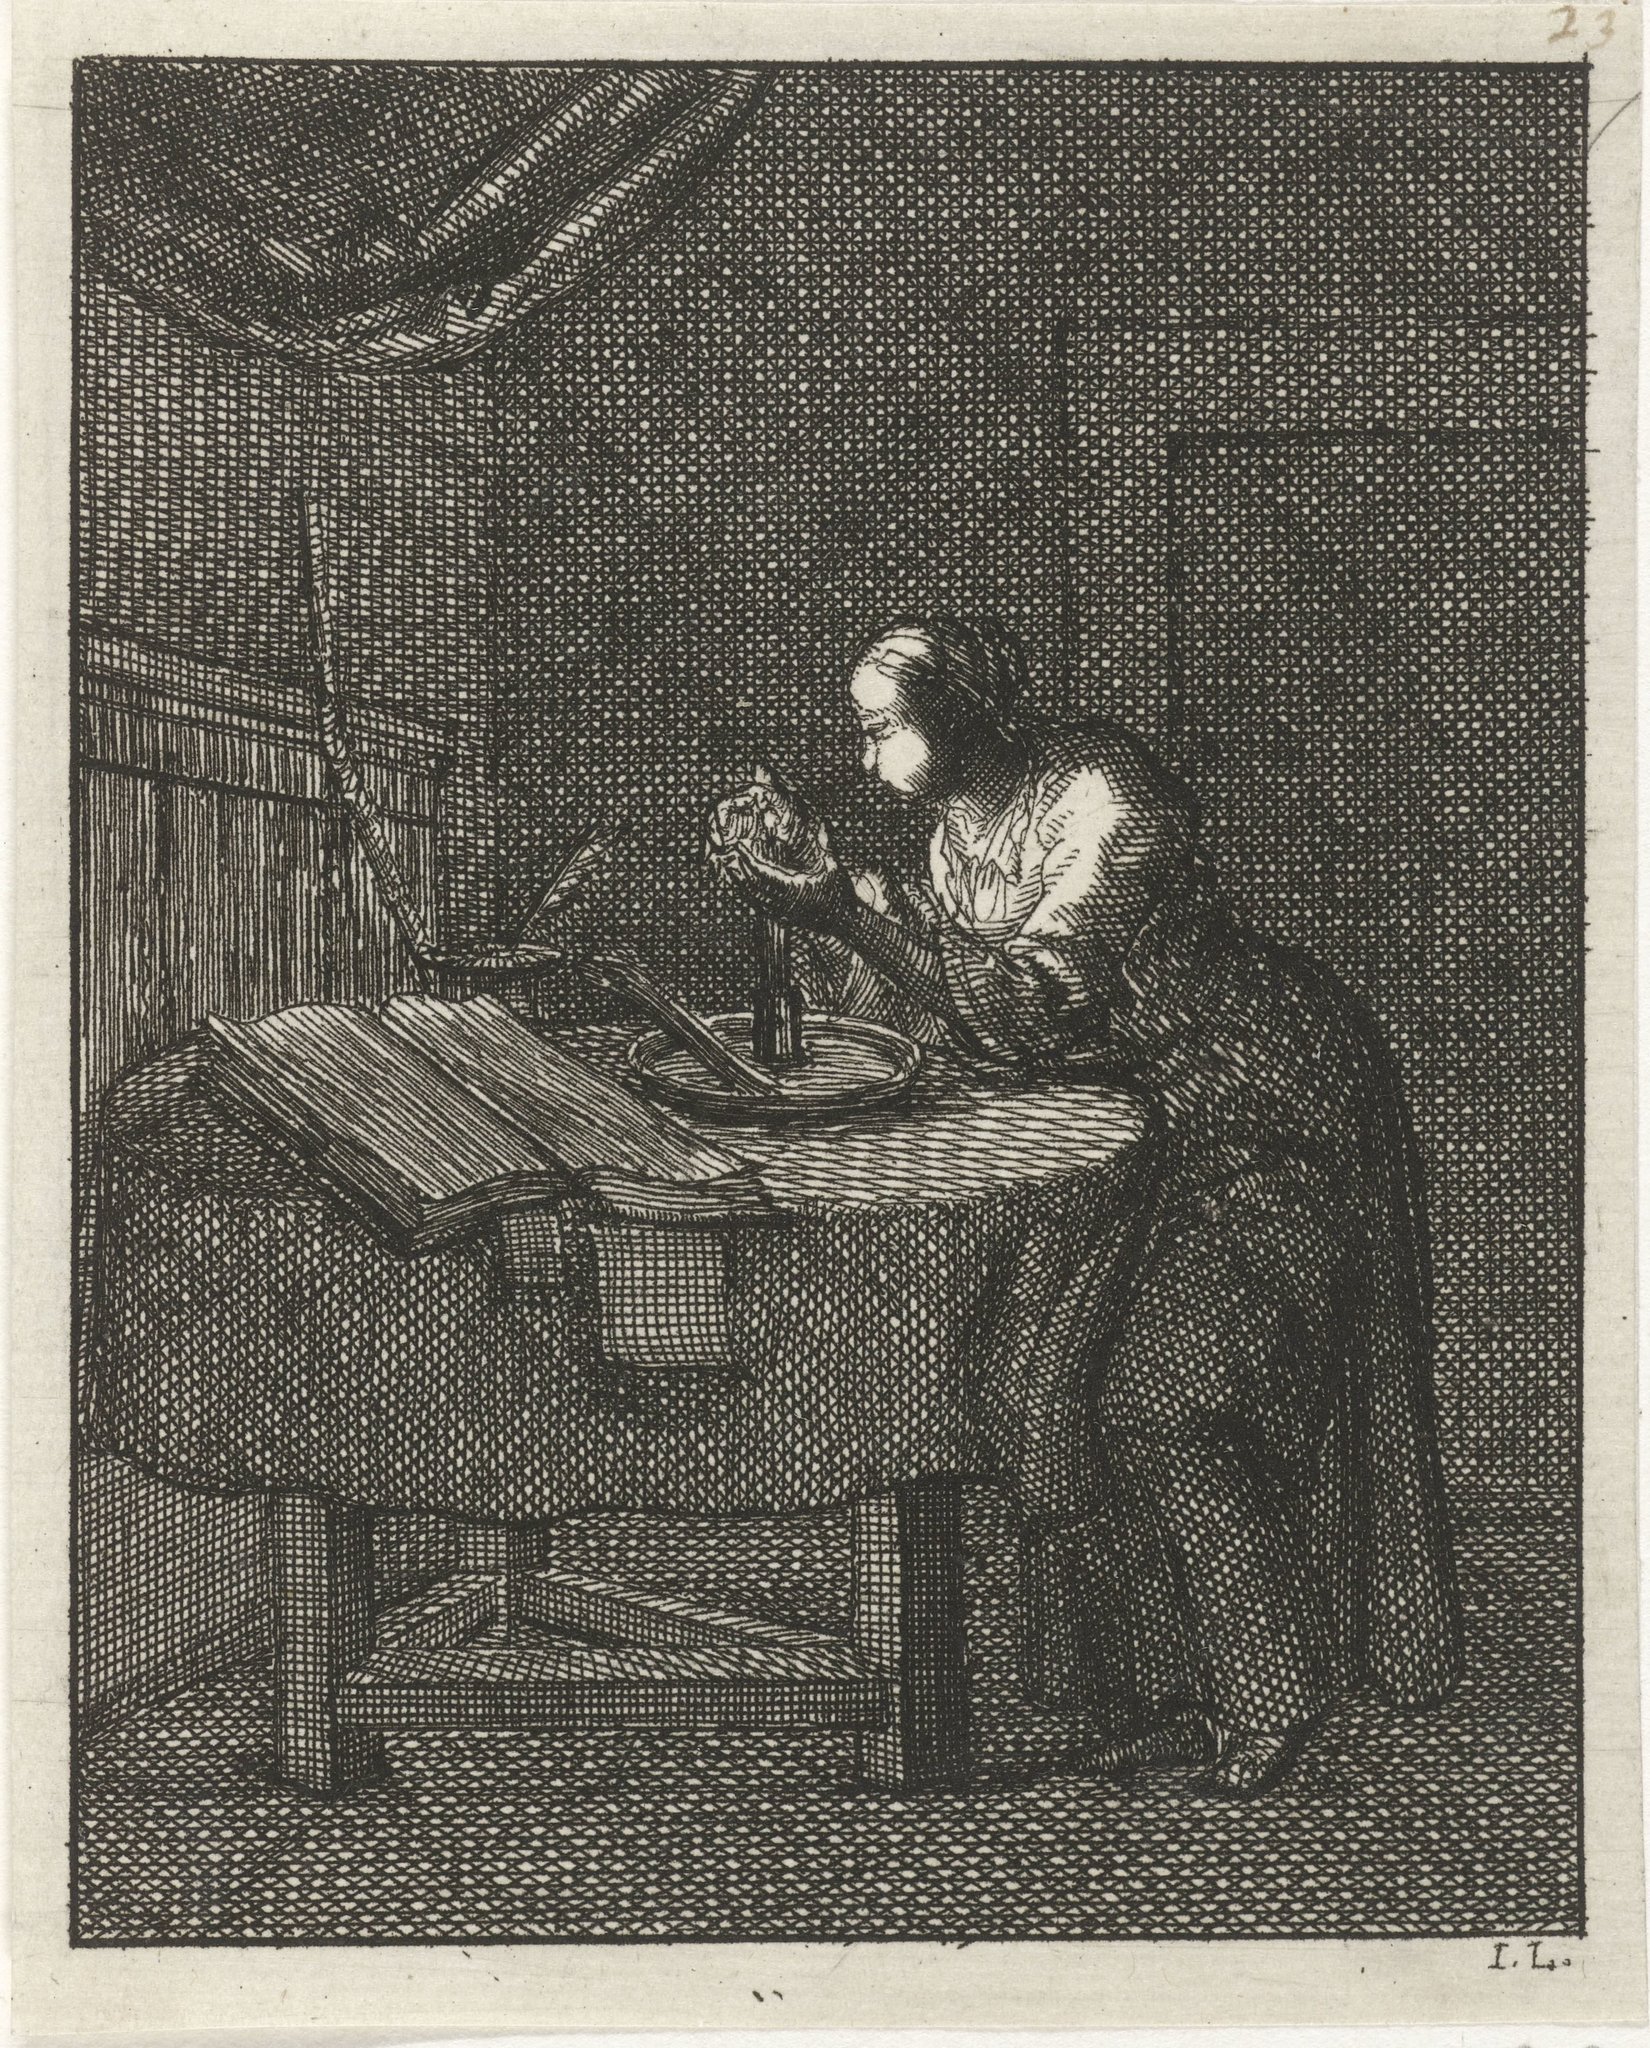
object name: book illustration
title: Daar leven is, is hoop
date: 1687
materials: paper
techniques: etching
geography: amsterdam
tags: candle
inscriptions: collector's mark: Lugt 2228, number: ‘23’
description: Illustratie uit: Luyken, Jan. Voncken der liefde Jesu, van het godtbegerende zielenvier. Amsterdam: Pieter Arentsz (II), 1687, p. 94.